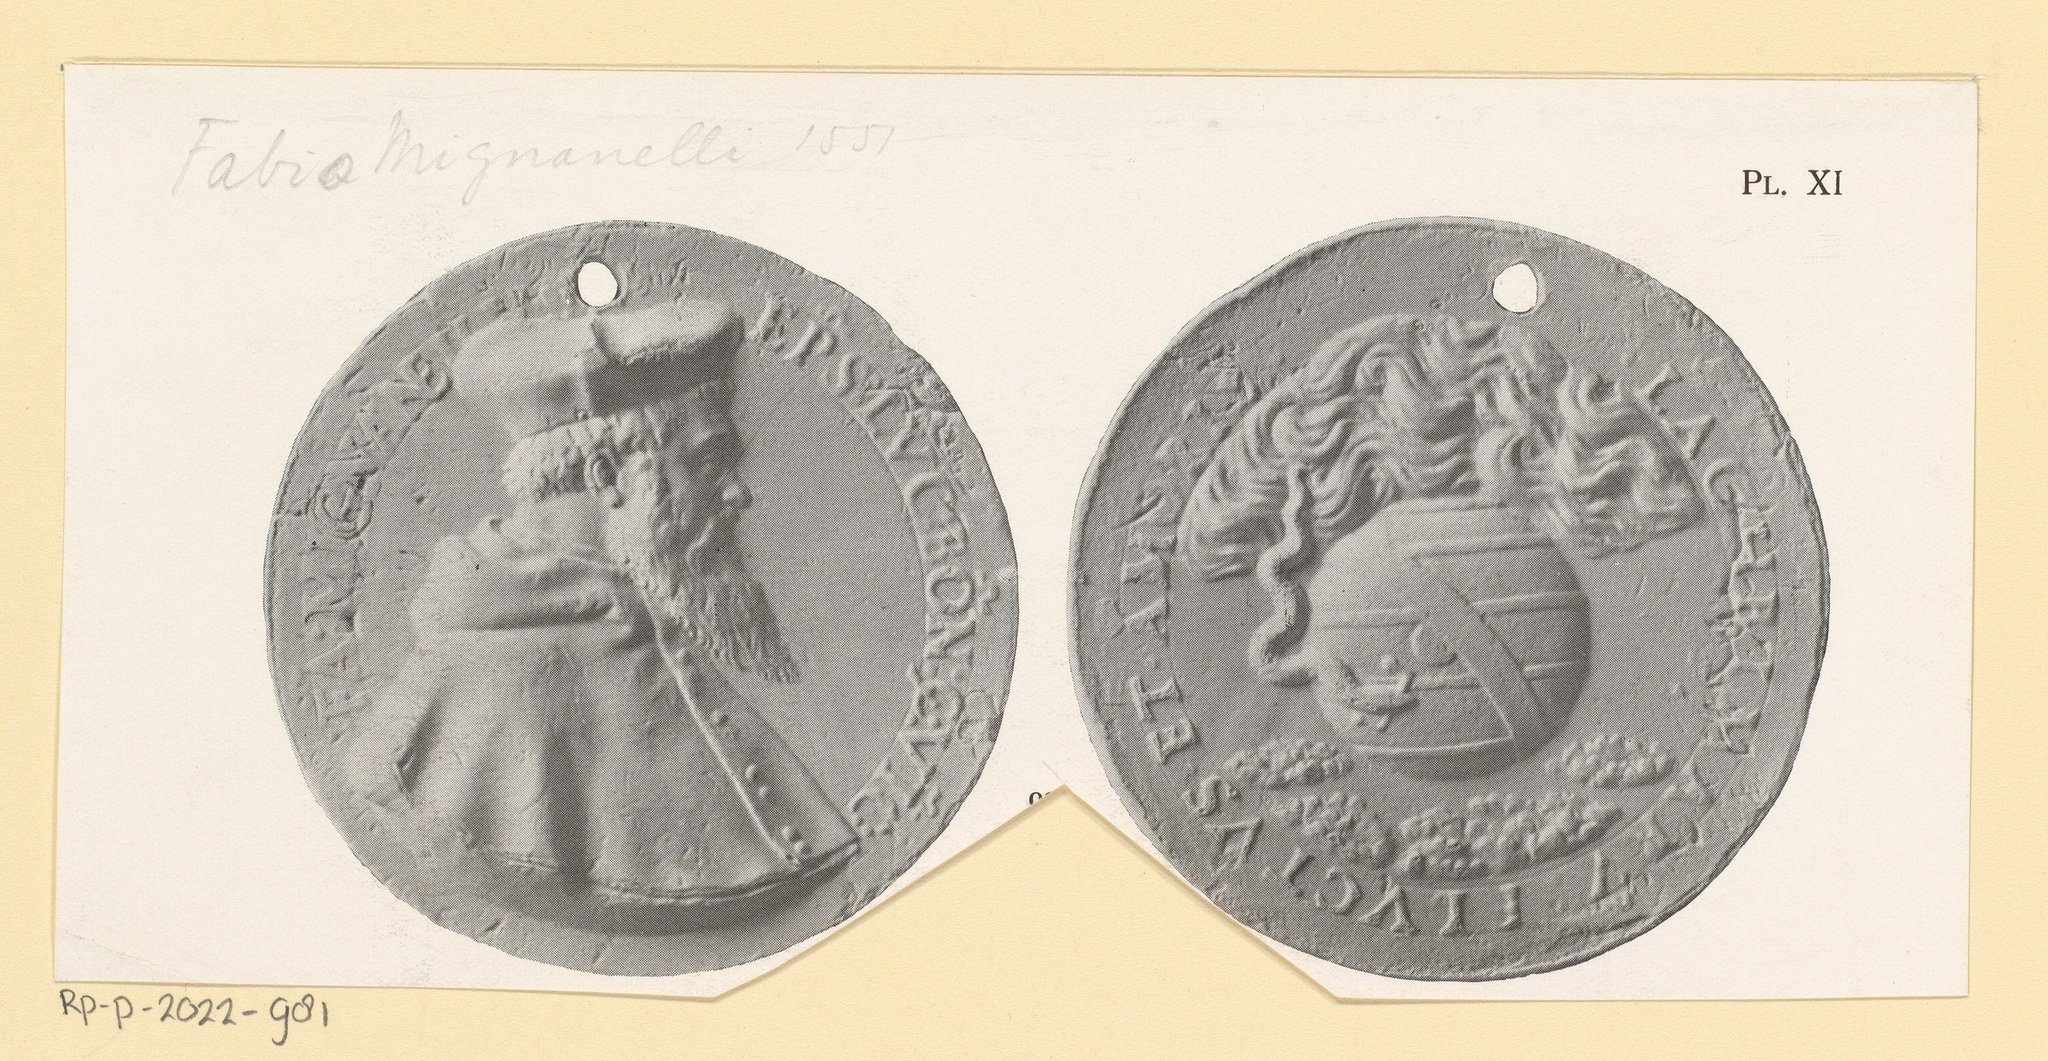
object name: photomechanical print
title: Penning met het portret van Fabio Mignanelli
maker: Anonymous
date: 1882-1970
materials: paper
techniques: autotype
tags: rome, cardinal, historical persons